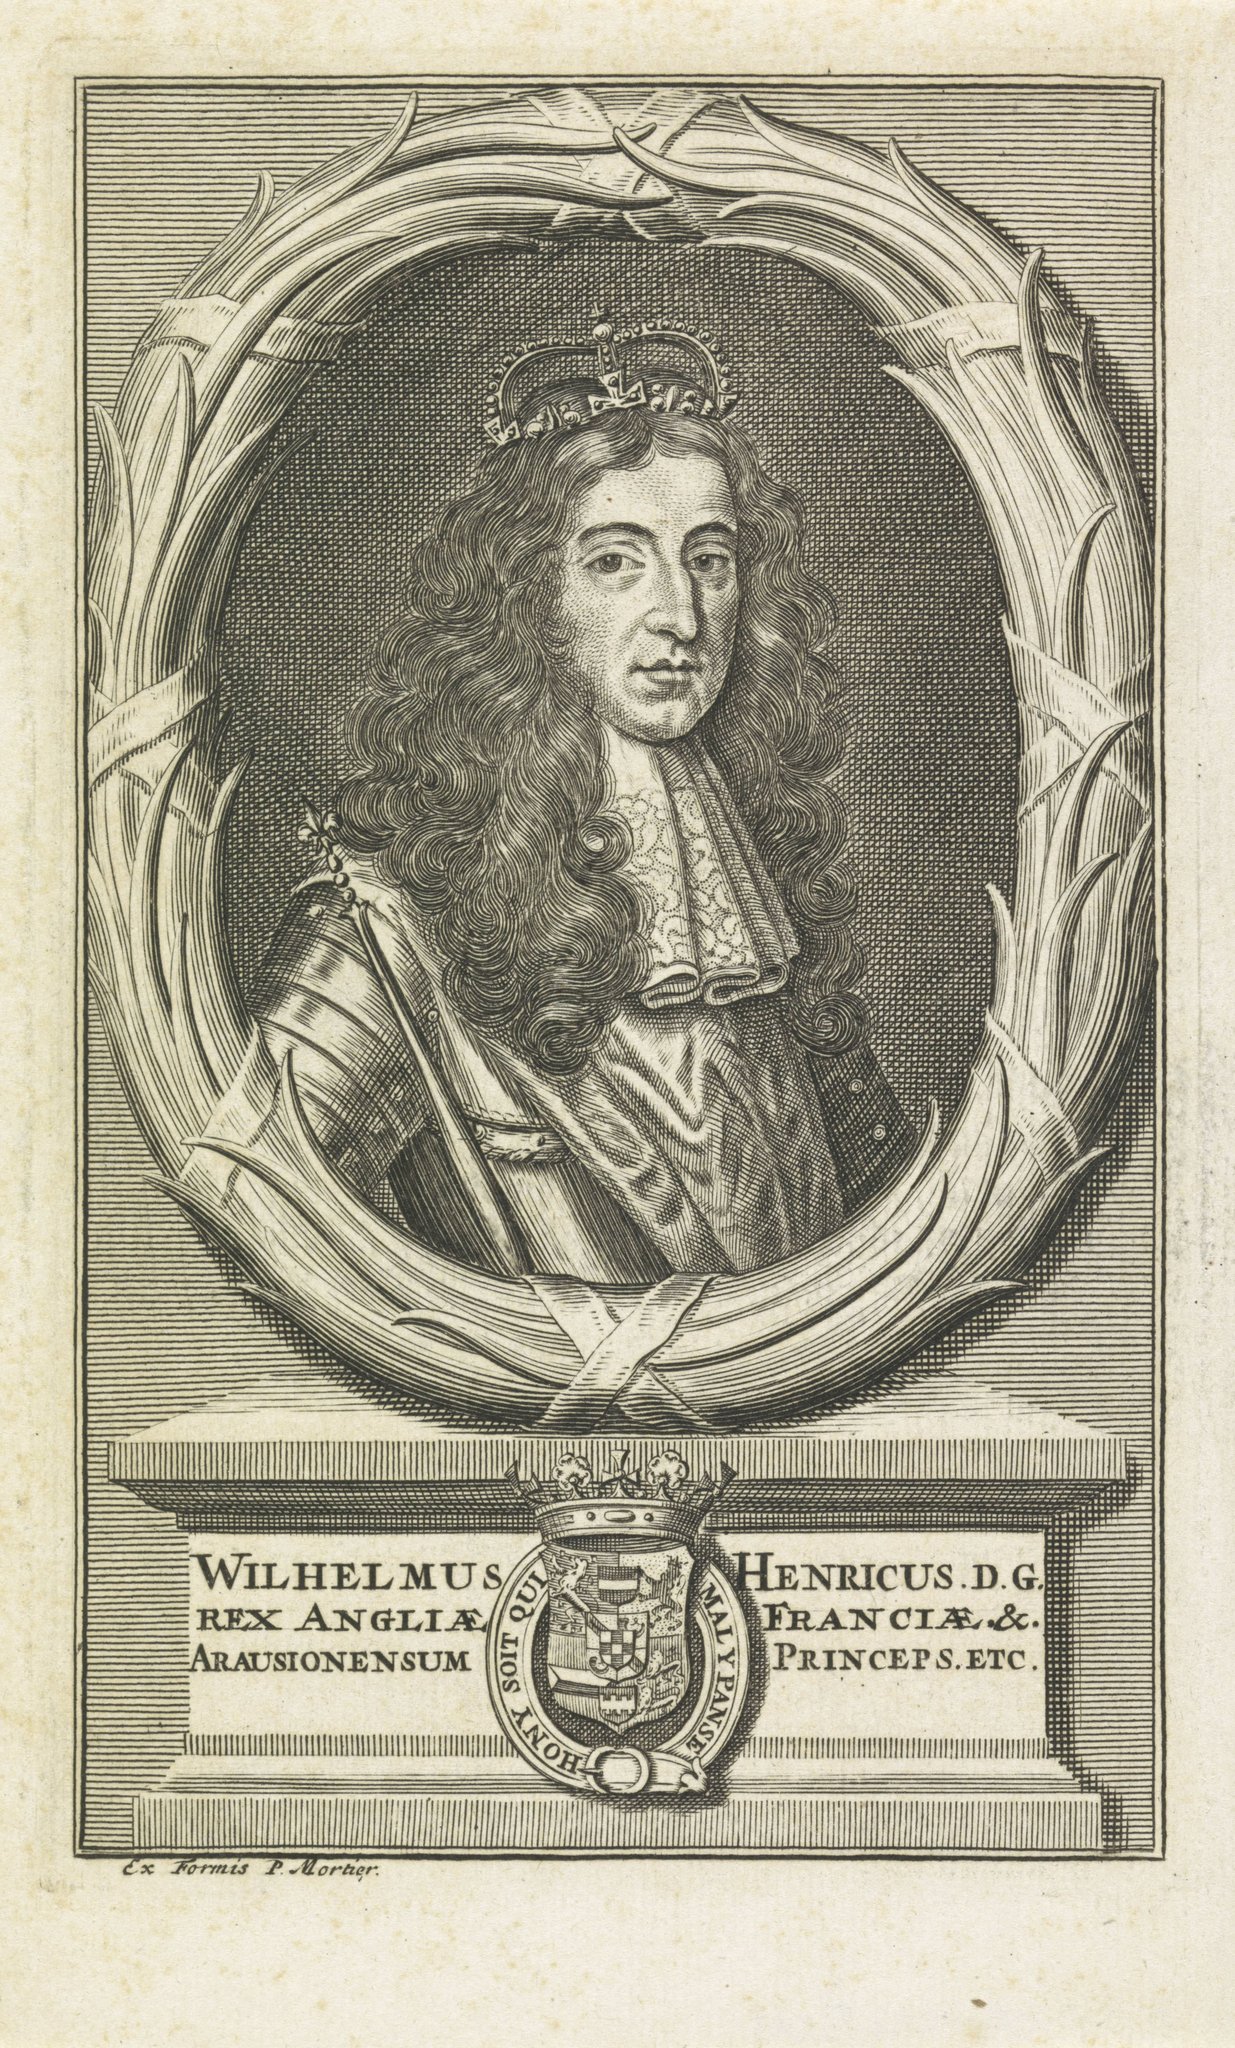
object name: print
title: Portret van Willem III, prins van Oranje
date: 1688-1711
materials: paper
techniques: engraving, etching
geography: low countries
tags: william iii (prince of orange and king of england, scotland, and ireland), knighthood order (garter) - insignia of a knighthood order, e.g.: badge, chain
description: Portret van Willem III met een kroon in een ovaal van lauwerbladen. Midden onder zijn wapen met een kroon, gedecoreerd met de Kousenband en het devies van de Orde van de Kousenband. Op een voetstuk zijn naam en titels.